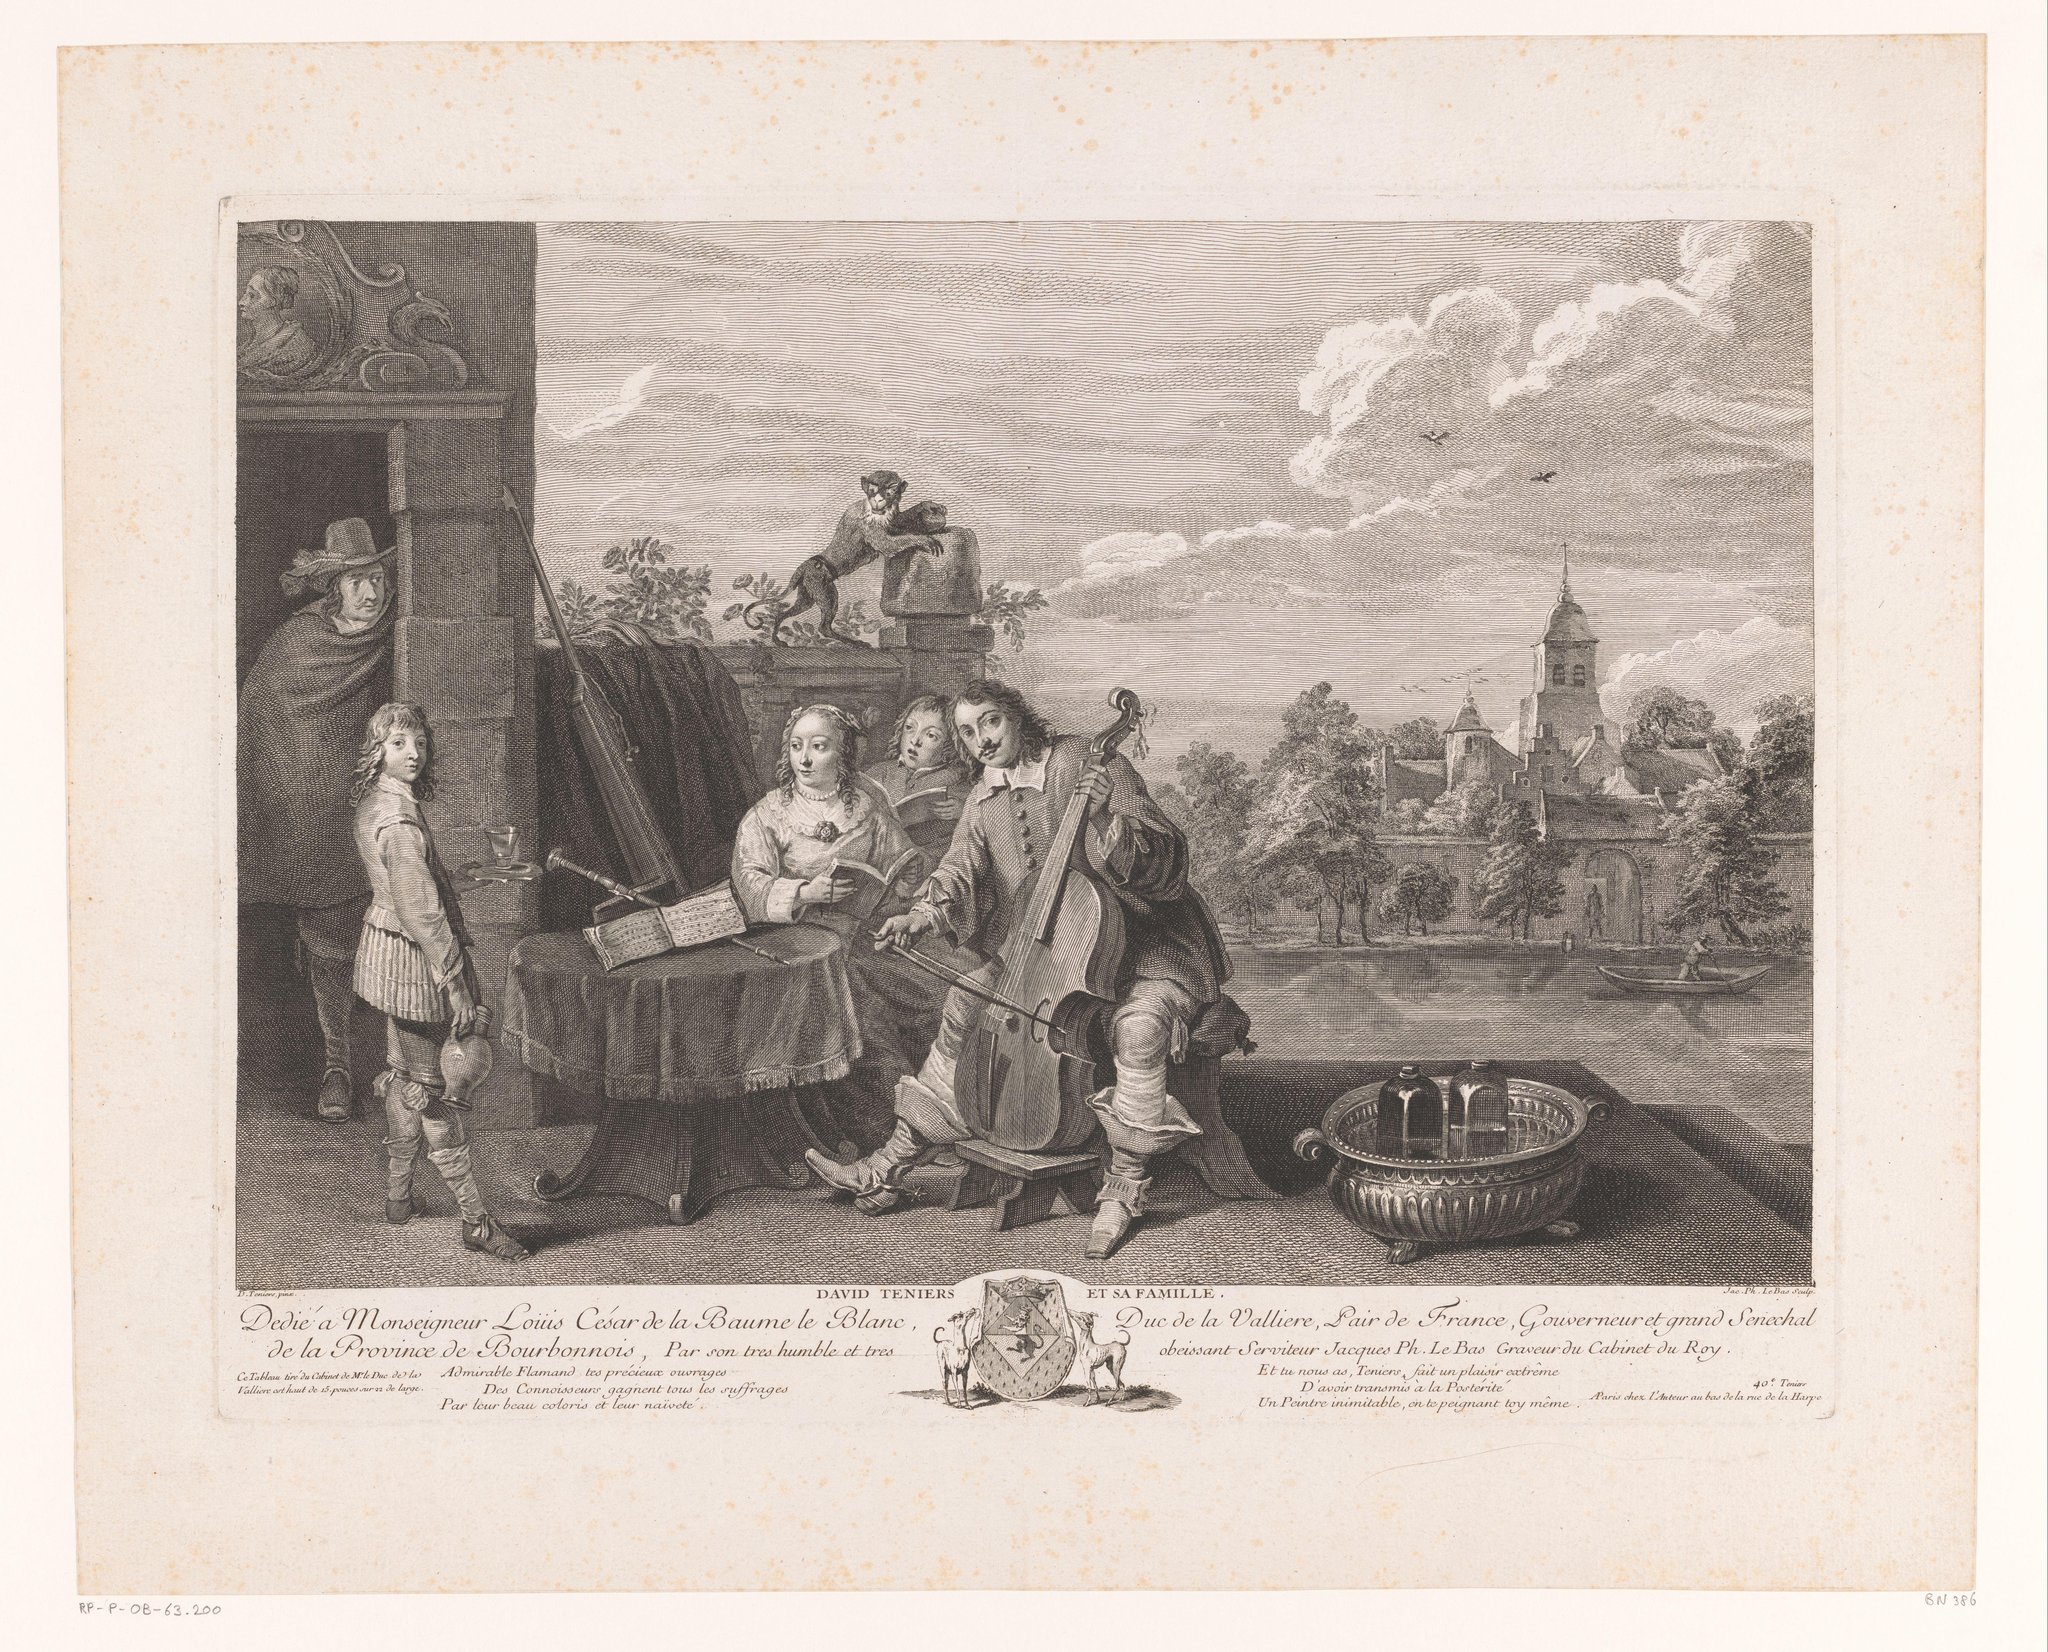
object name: print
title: Zelfportret van David (II) Teniers met zijn familie op een bordes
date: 1747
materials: paper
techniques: engraving, etching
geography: paris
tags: antwerp, brussels, painter, print maker, draughtsman, david teniers (ii), historical persons, portrait, self-portrait of artist, more than one musician with instrument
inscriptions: collector's mark: Lugt 240